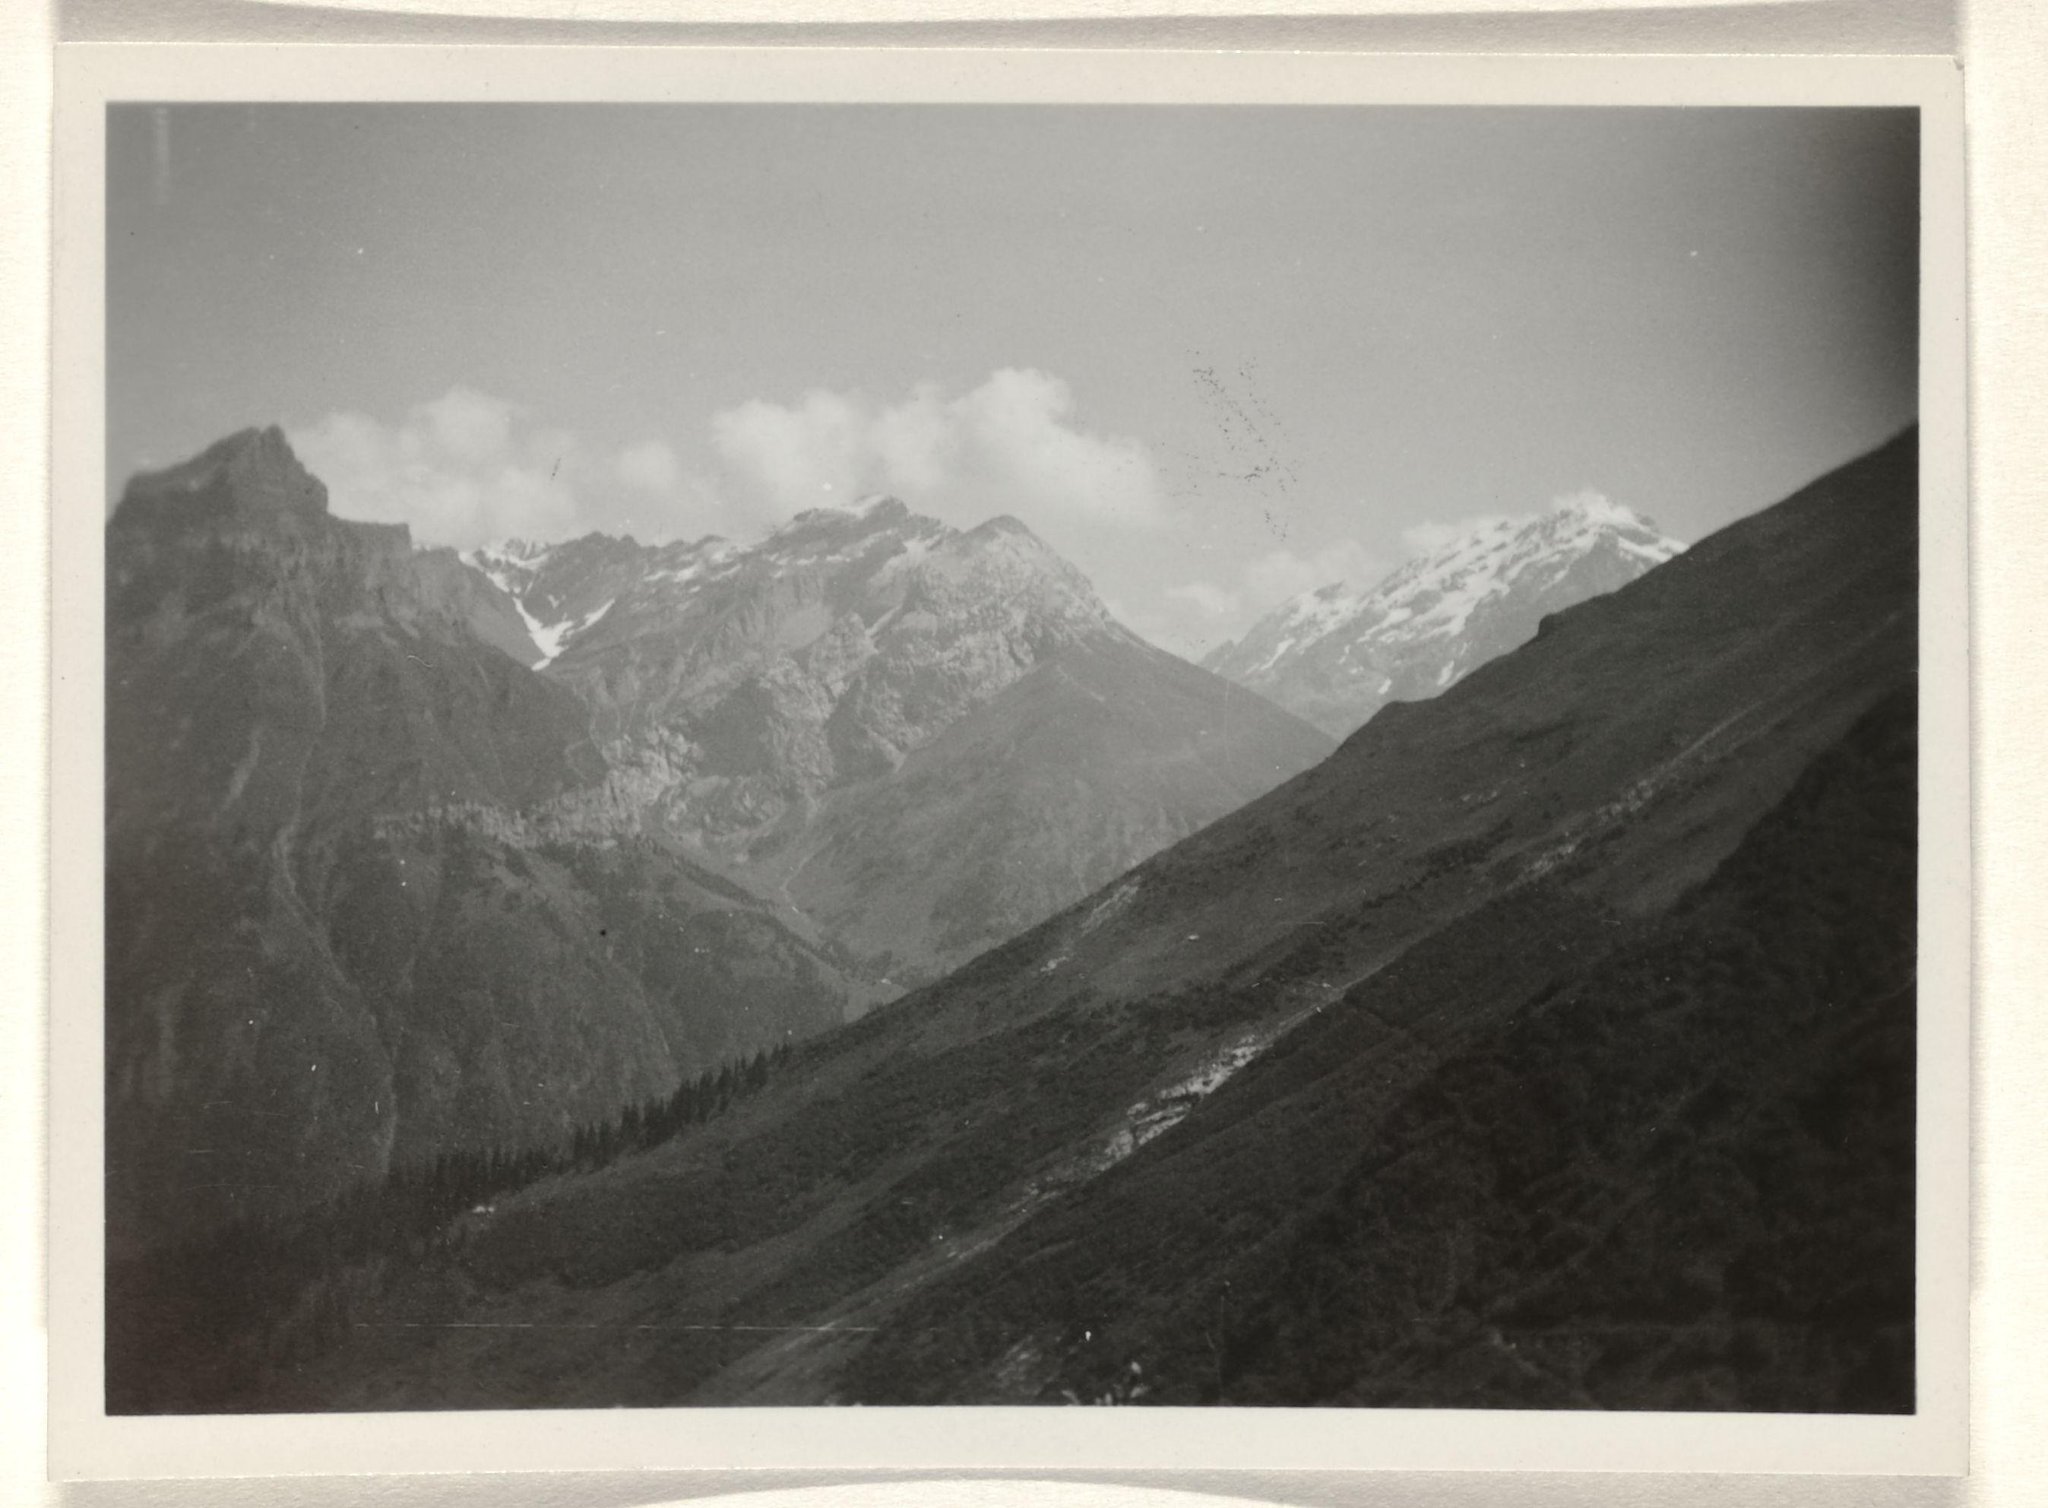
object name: photograph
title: Besneeuwd berglandschap met wolken op de achtergrond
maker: Anonymous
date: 1908-1935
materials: photographic support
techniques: gelatin silver print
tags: trübsee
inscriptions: date: ‘Aug. 1935 28’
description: Besneeuwd berglandschap met wolken op de achtergrond.